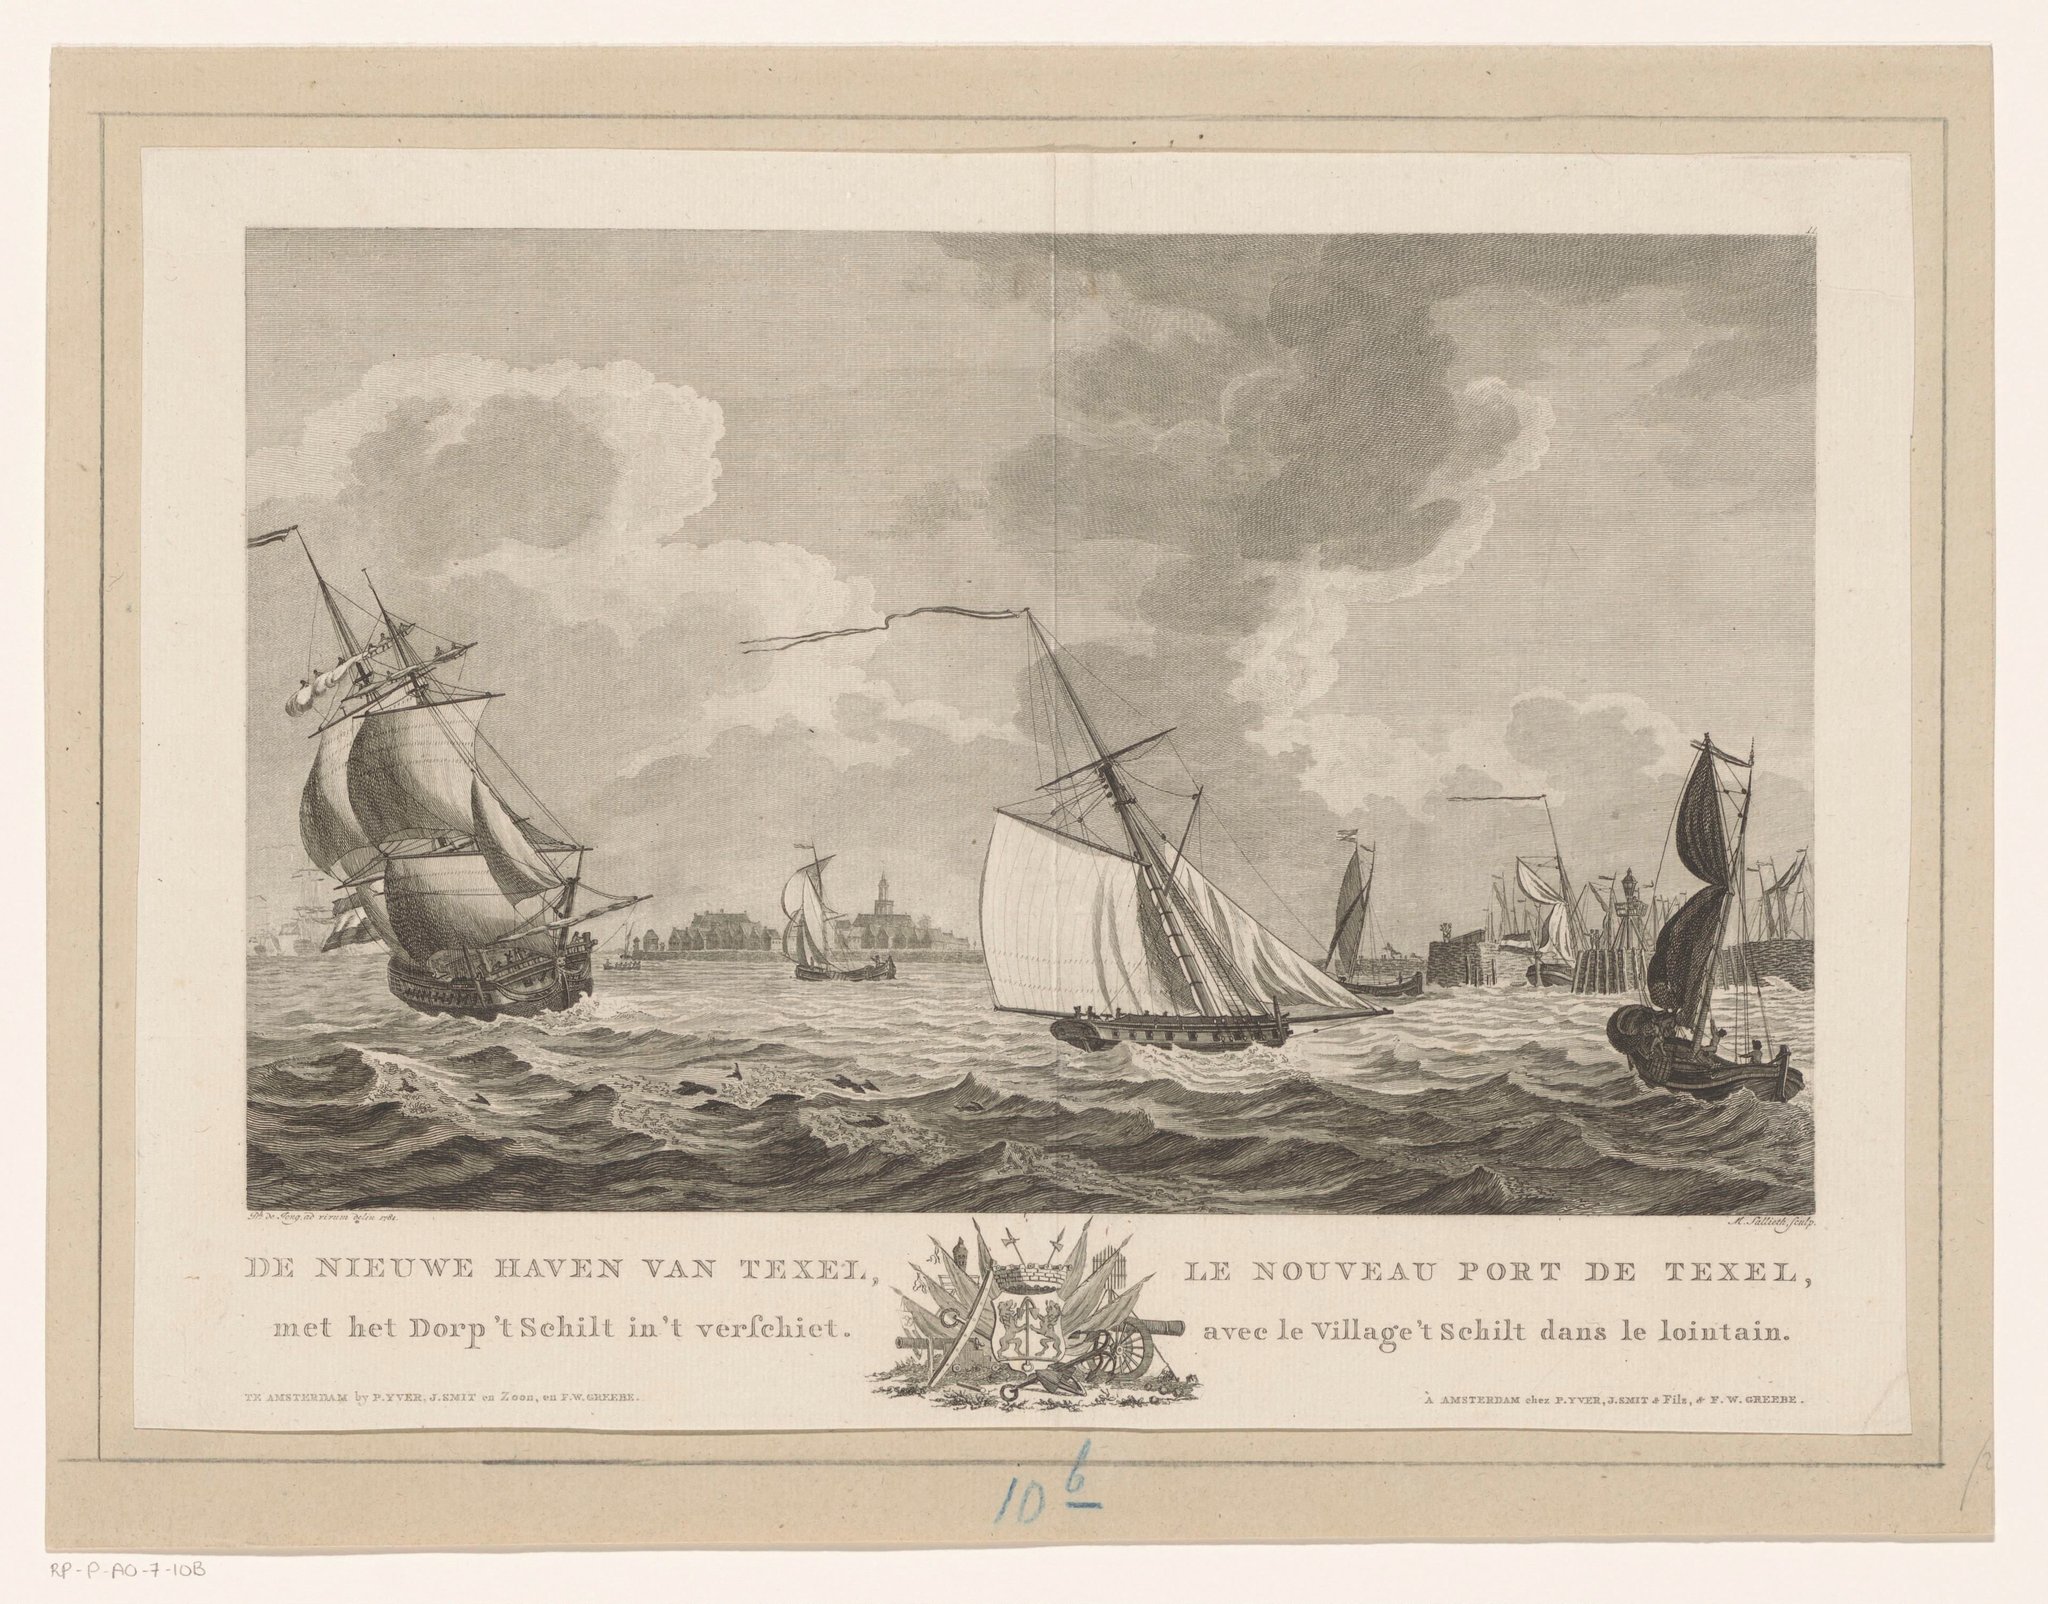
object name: print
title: Gezicht op de Nieuwe Haven van Texel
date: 1781-1787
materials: paper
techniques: etching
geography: amsterdam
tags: harbour, coat of arms (as symbol of the state, etc.), coat of arms (as symbol of the state, etc.) (+ city; municipal), sailing-ship, sailing-boat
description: Latere staat ook gebruikt in: Aa, Cornelis van der. Atlas van de zeehavens der Bataafsche Republiek. Met derzelver beschrijvingen in XXXI kunstplaaten / Atlas van de zeehavens der Bataafsche Republiek, die van Batavia en Onrust. Mitsgaders de afbeeldingen van de haringvisscherij en de walvischvangst (…). Amsterdam: Evert Maaskamp, 1805.